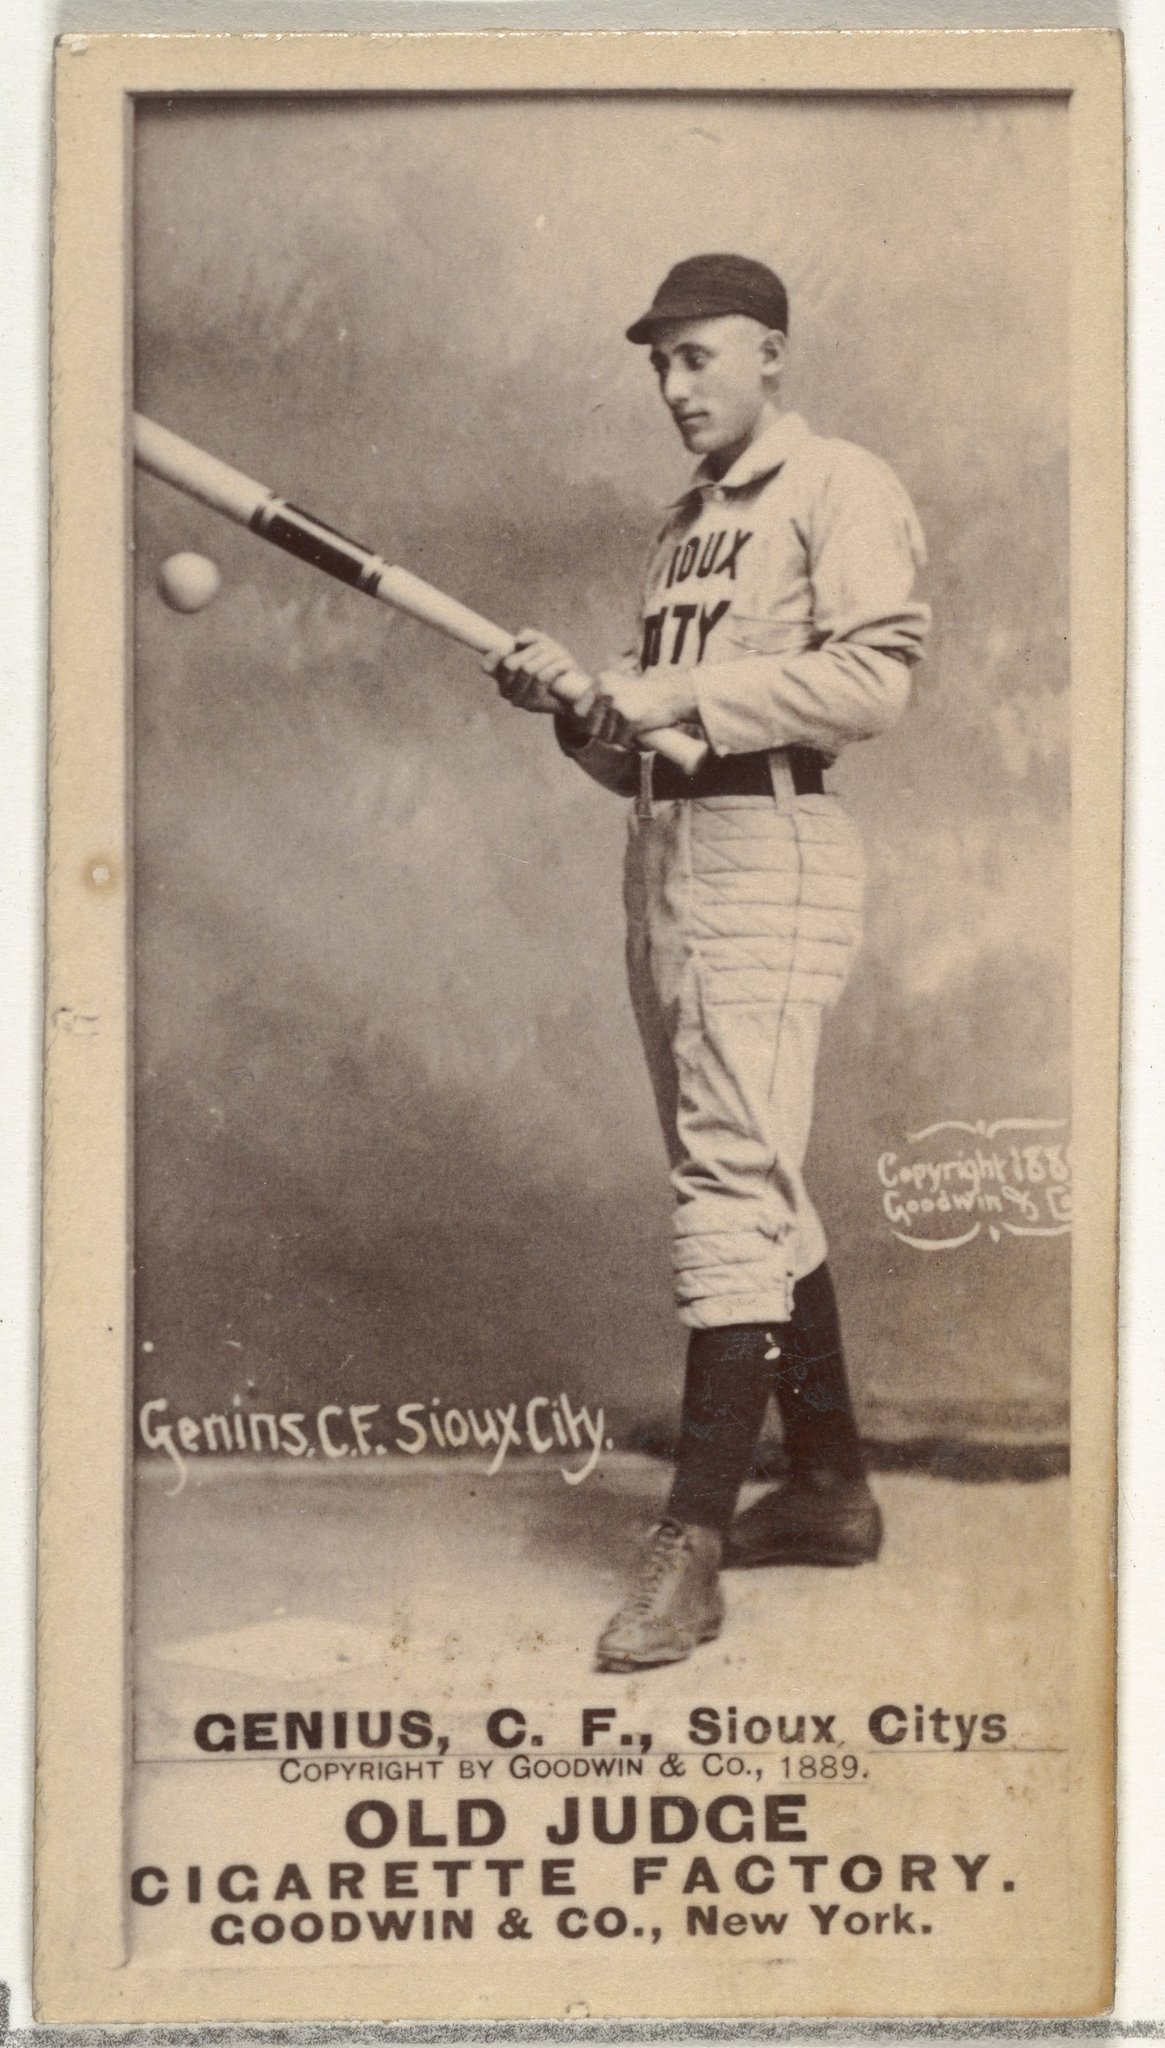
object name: baseball card, photograph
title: C. Frank Genins, Center Field, Sioux City Corn Huskers, from the Old Judge series (N172) for Old Judge Cigarettes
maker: goodwin & company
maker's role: publisher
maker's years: 1850-1950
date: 1889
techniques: albumen silver print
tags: men,portraits,baseball,athletes